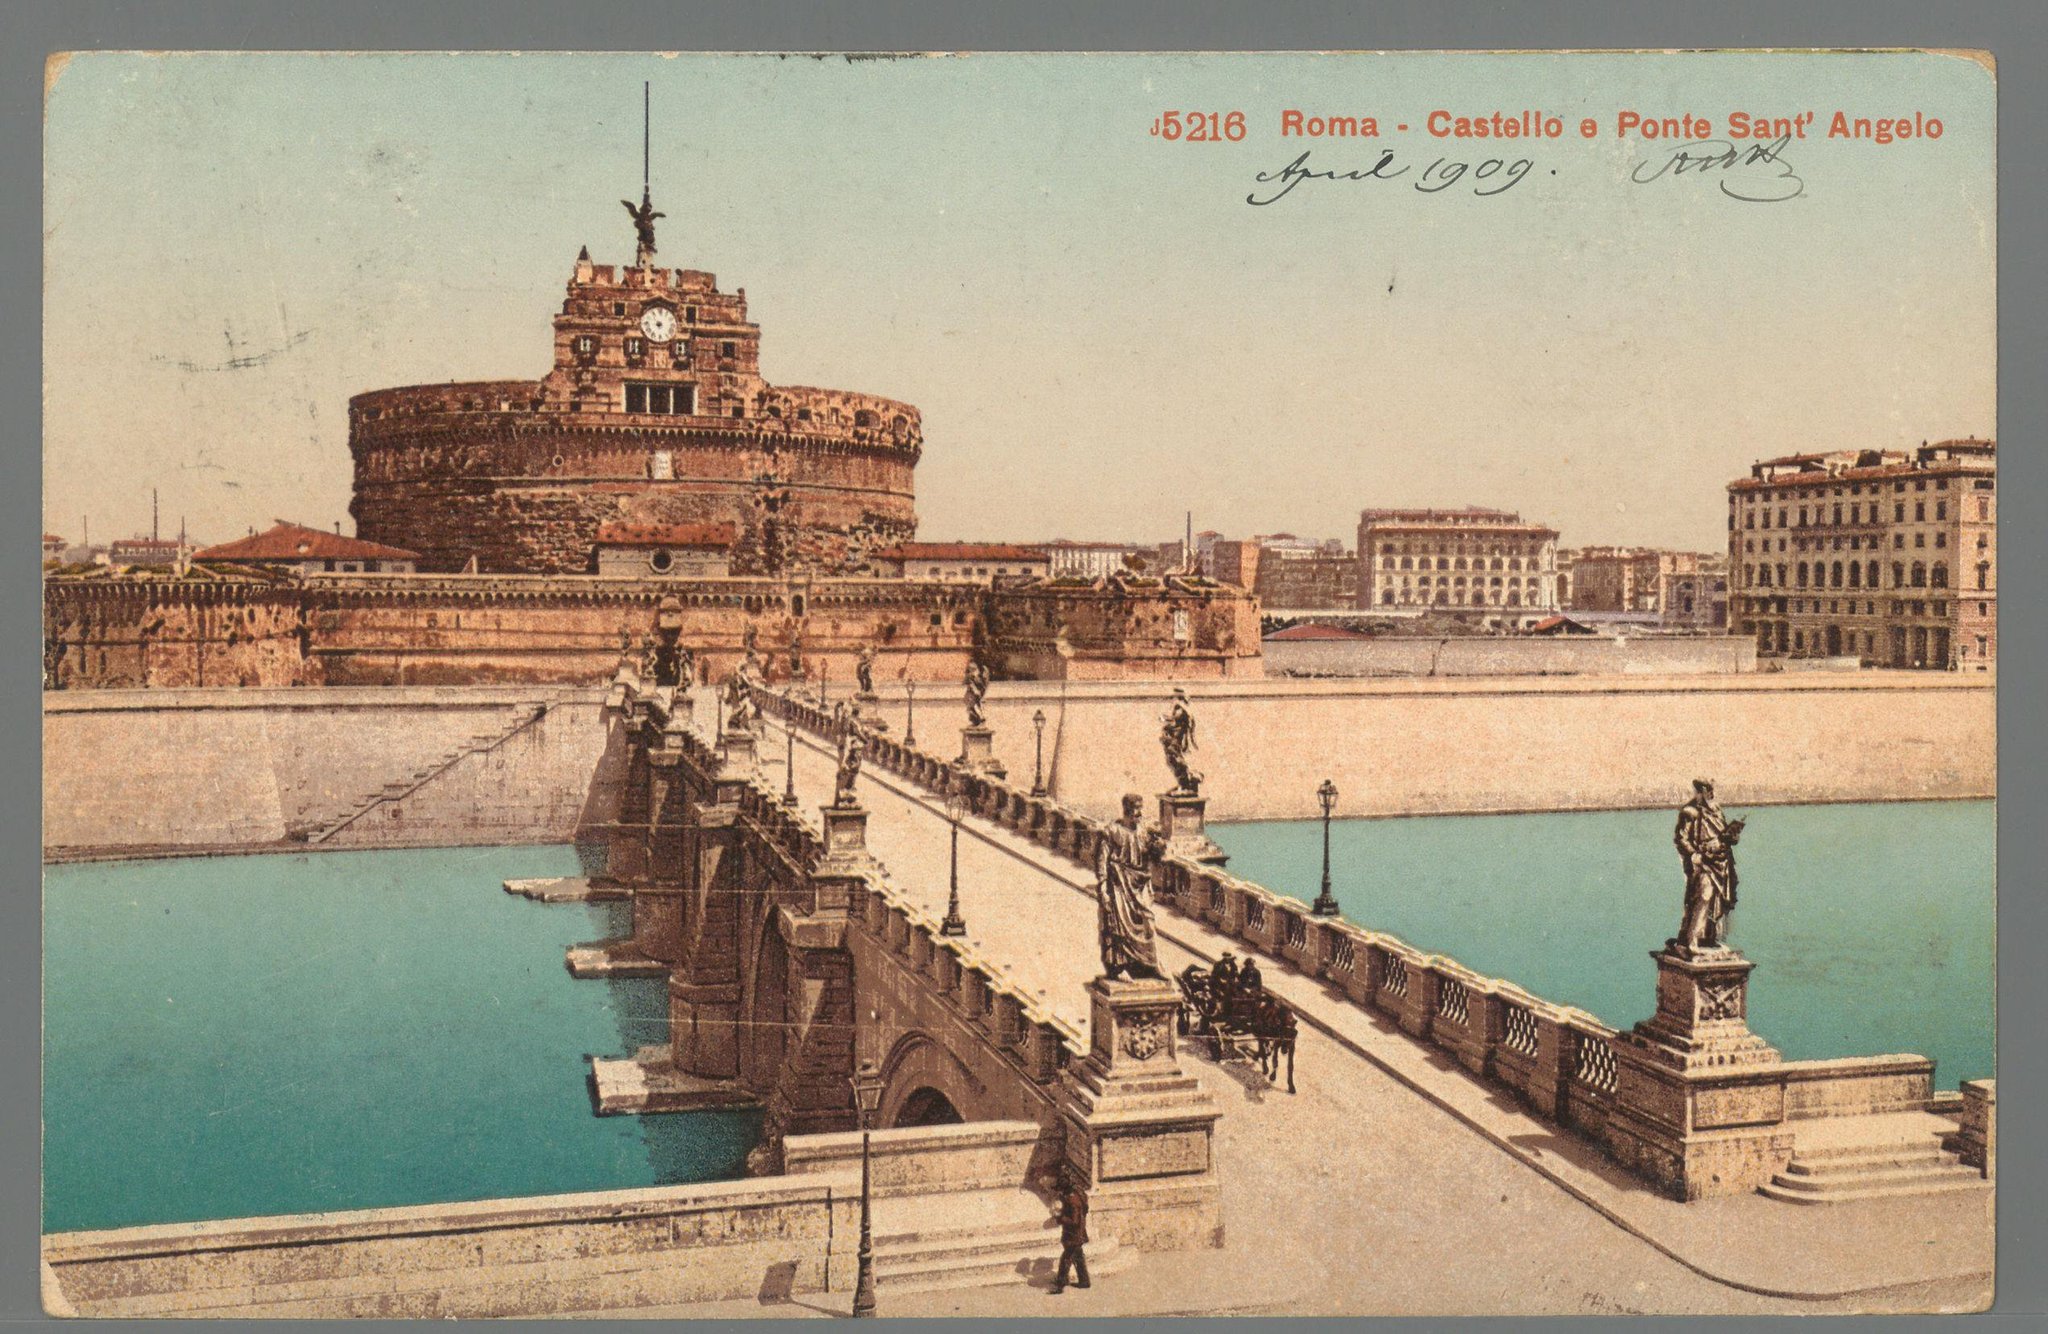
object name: ansichtkaart, prentbriefkaart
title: Roma. Castello e Ponte Sant'Angelo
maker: Anonymous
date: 1905-1909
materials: cardboard, photographic process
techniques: writing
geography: rome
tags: fortress, city-view, and landscape with man-made constructions, bridge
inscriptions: postage stamp